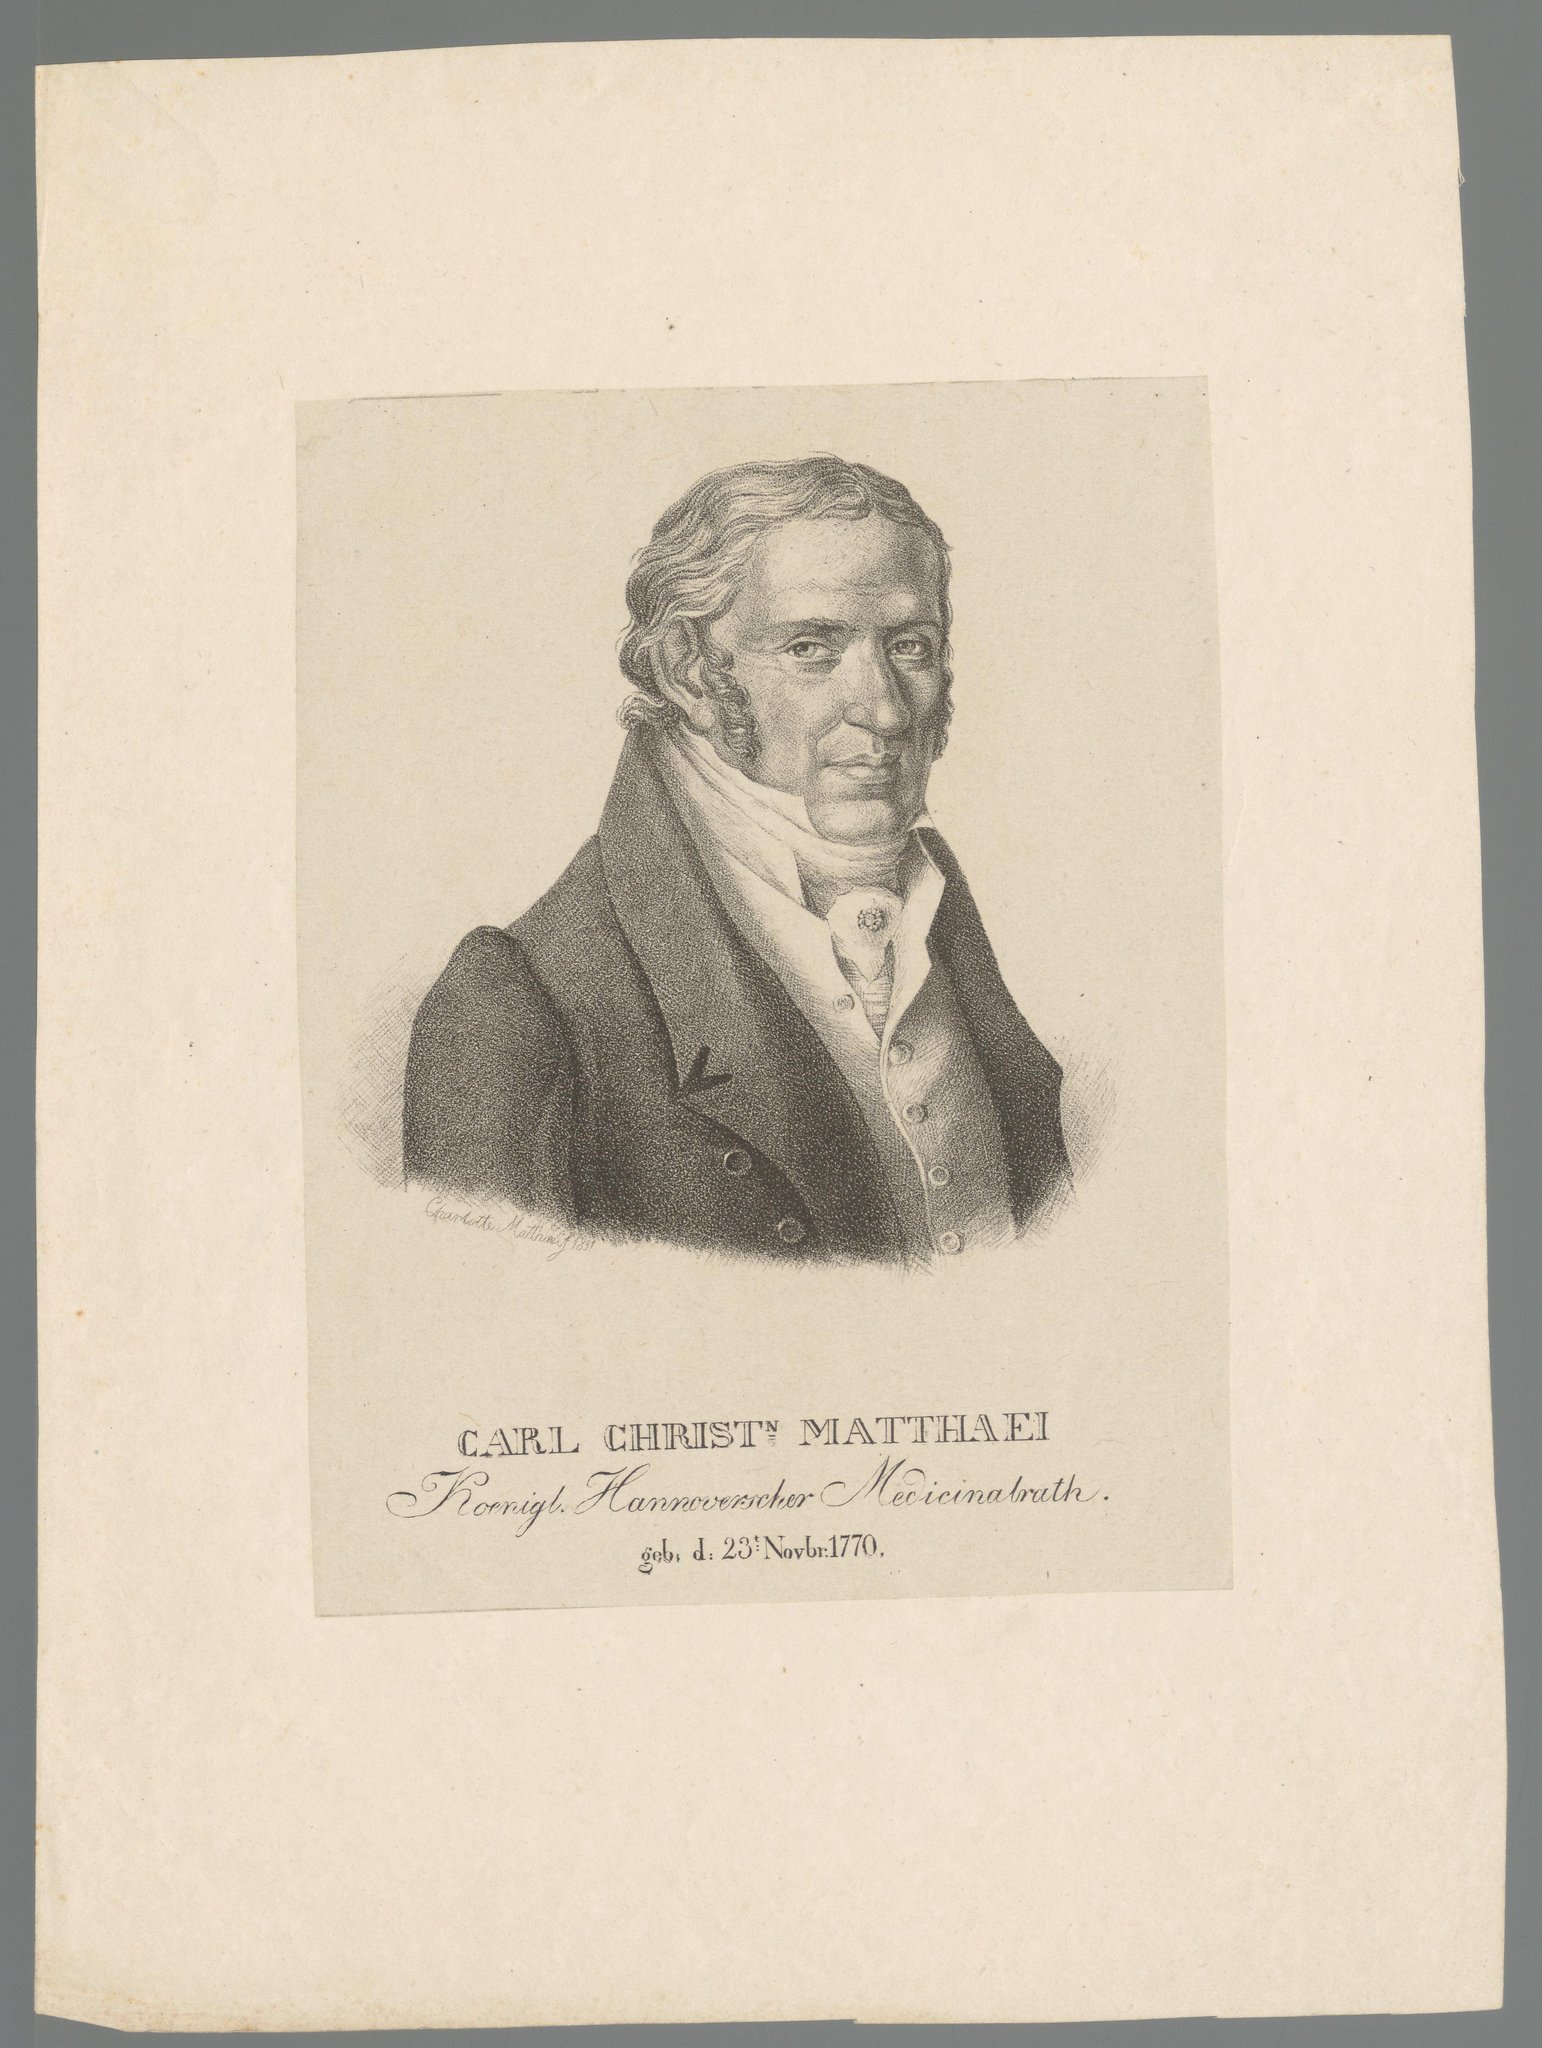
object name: print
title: Portret van Karl Christian Matthaei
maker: charlotte matthaei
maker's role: print maker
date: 1831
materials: paper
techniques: lithograph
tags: verden, historical persons, physician, doctor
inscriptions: collector's mark: Lugt 2228